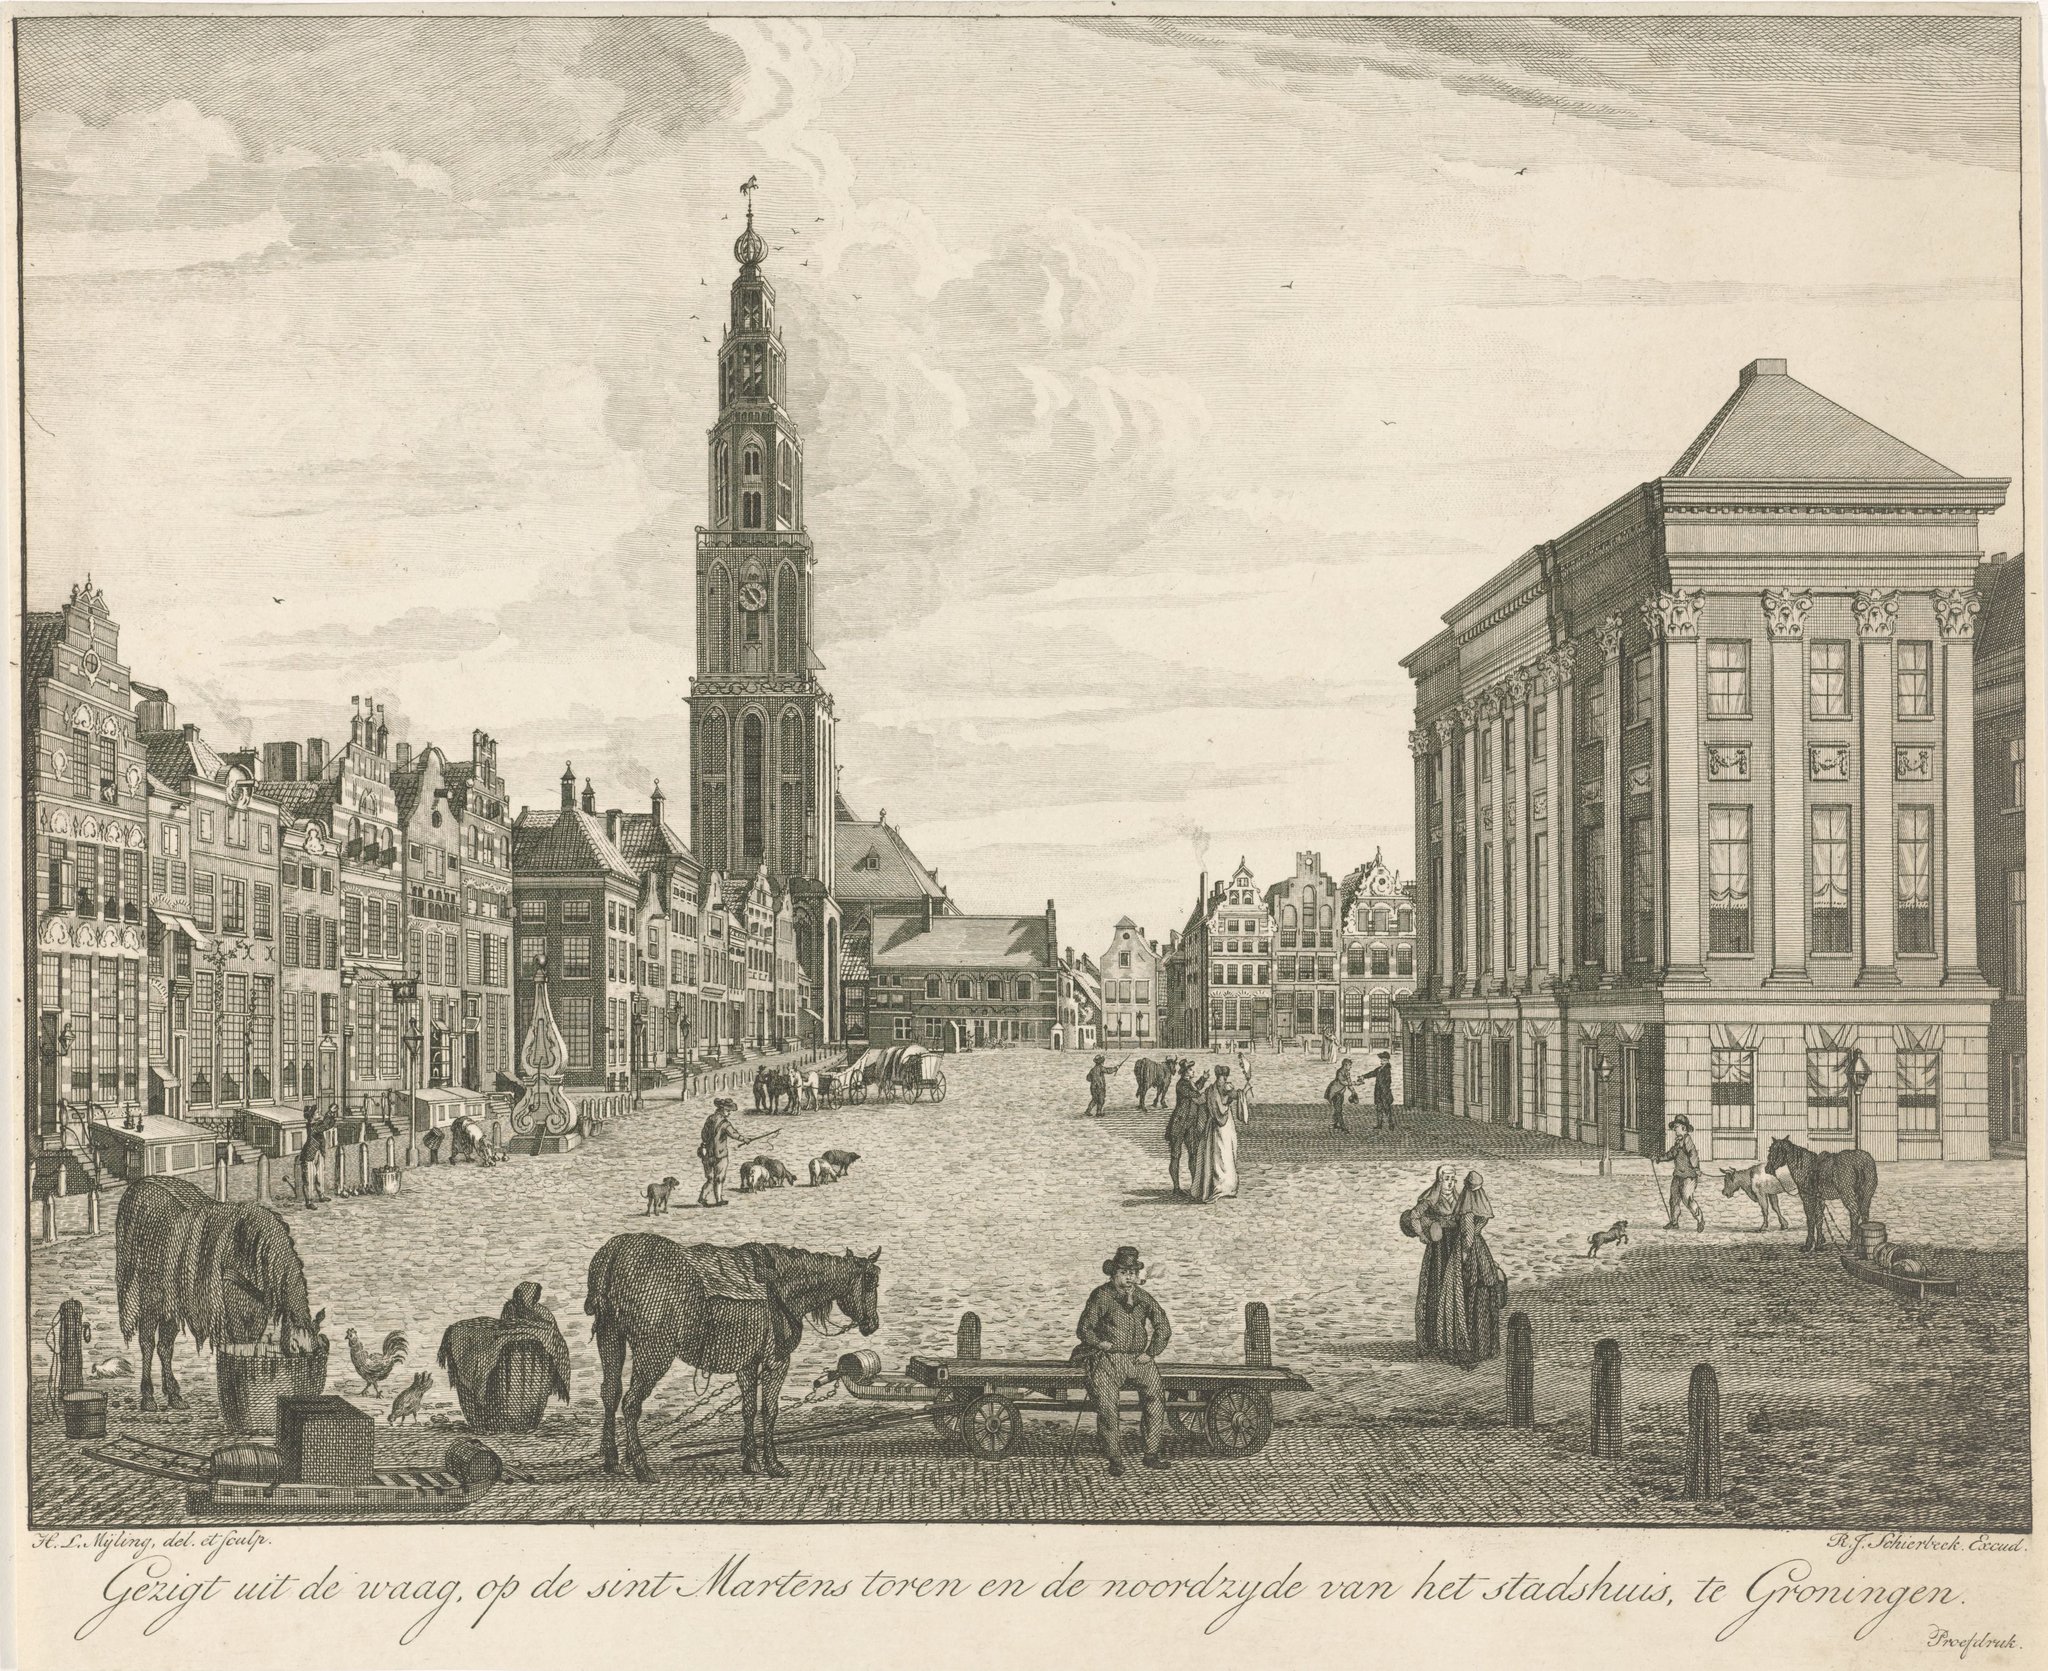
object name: print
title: Gezigt uit de waag, op de sint Martens toren en de noordzijde van het stadhuis, te Groningen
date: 1801-1821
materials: paper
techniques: etching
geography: groningen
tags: townhall, horse, parts of church exterior and annexes: tower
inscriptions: collector's mark: Lugt 2228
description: Gezicht op de Grote Markt met links de Martinitoren en rechts het stadhuis te Groningen. Op de voorgrond twee paarden en een man zittend op een kar.